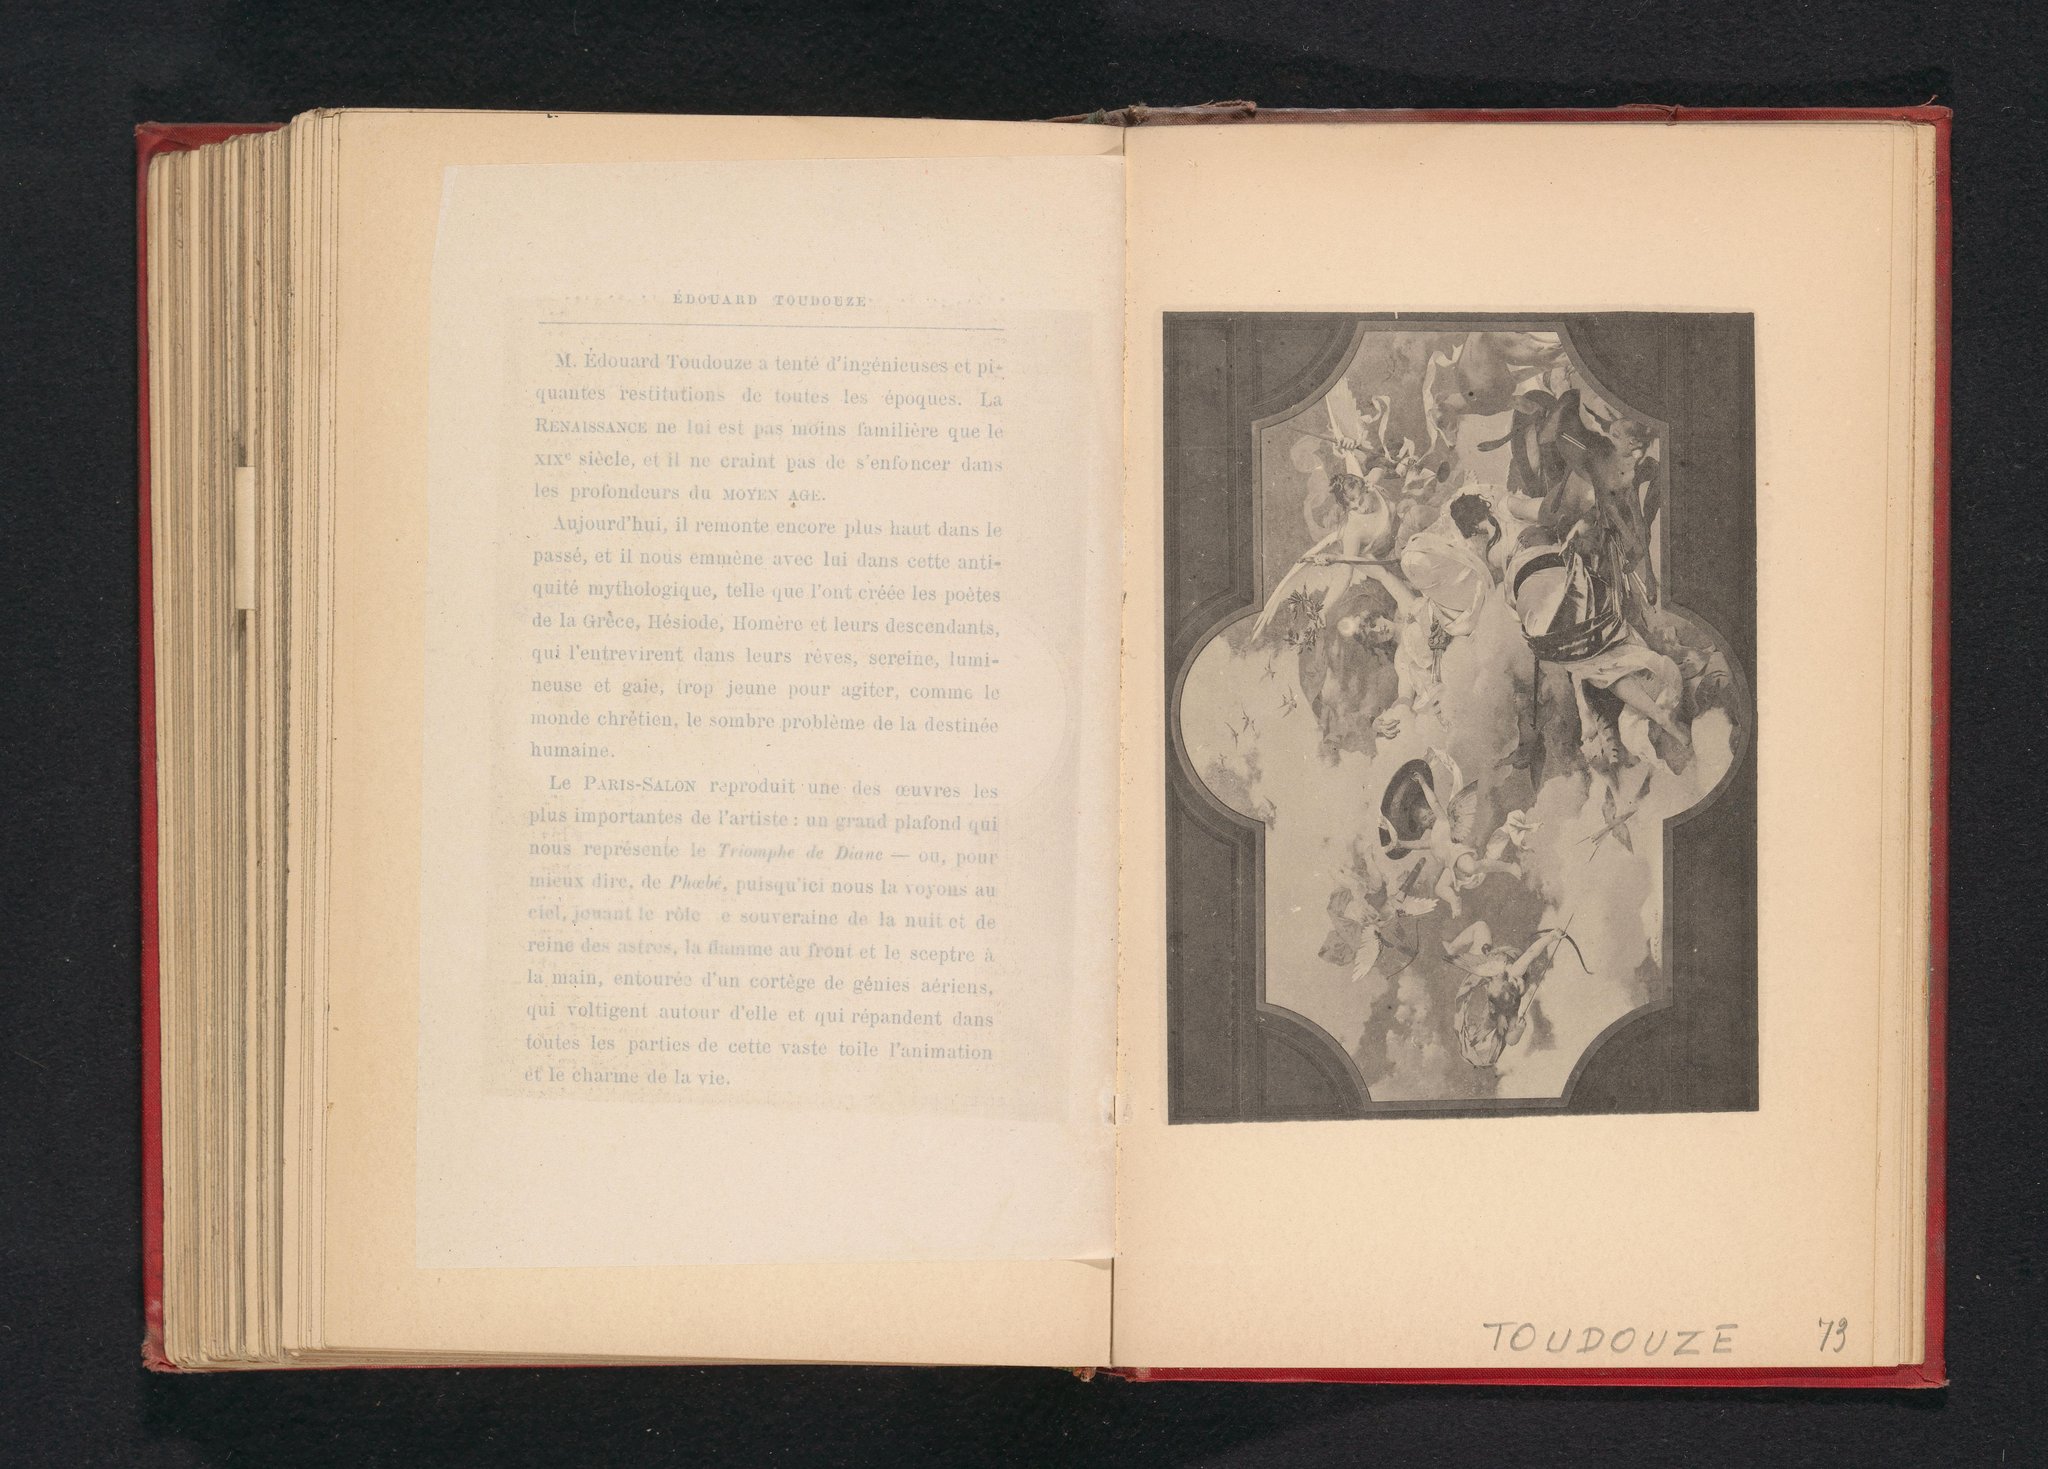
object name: page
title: Fotoreproductie van het schilderij Le triomphe de Diane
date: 1872-1882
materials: paper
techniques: photograph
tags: specific aspects, allegorical aspects of diana; diana as patroness - triumph